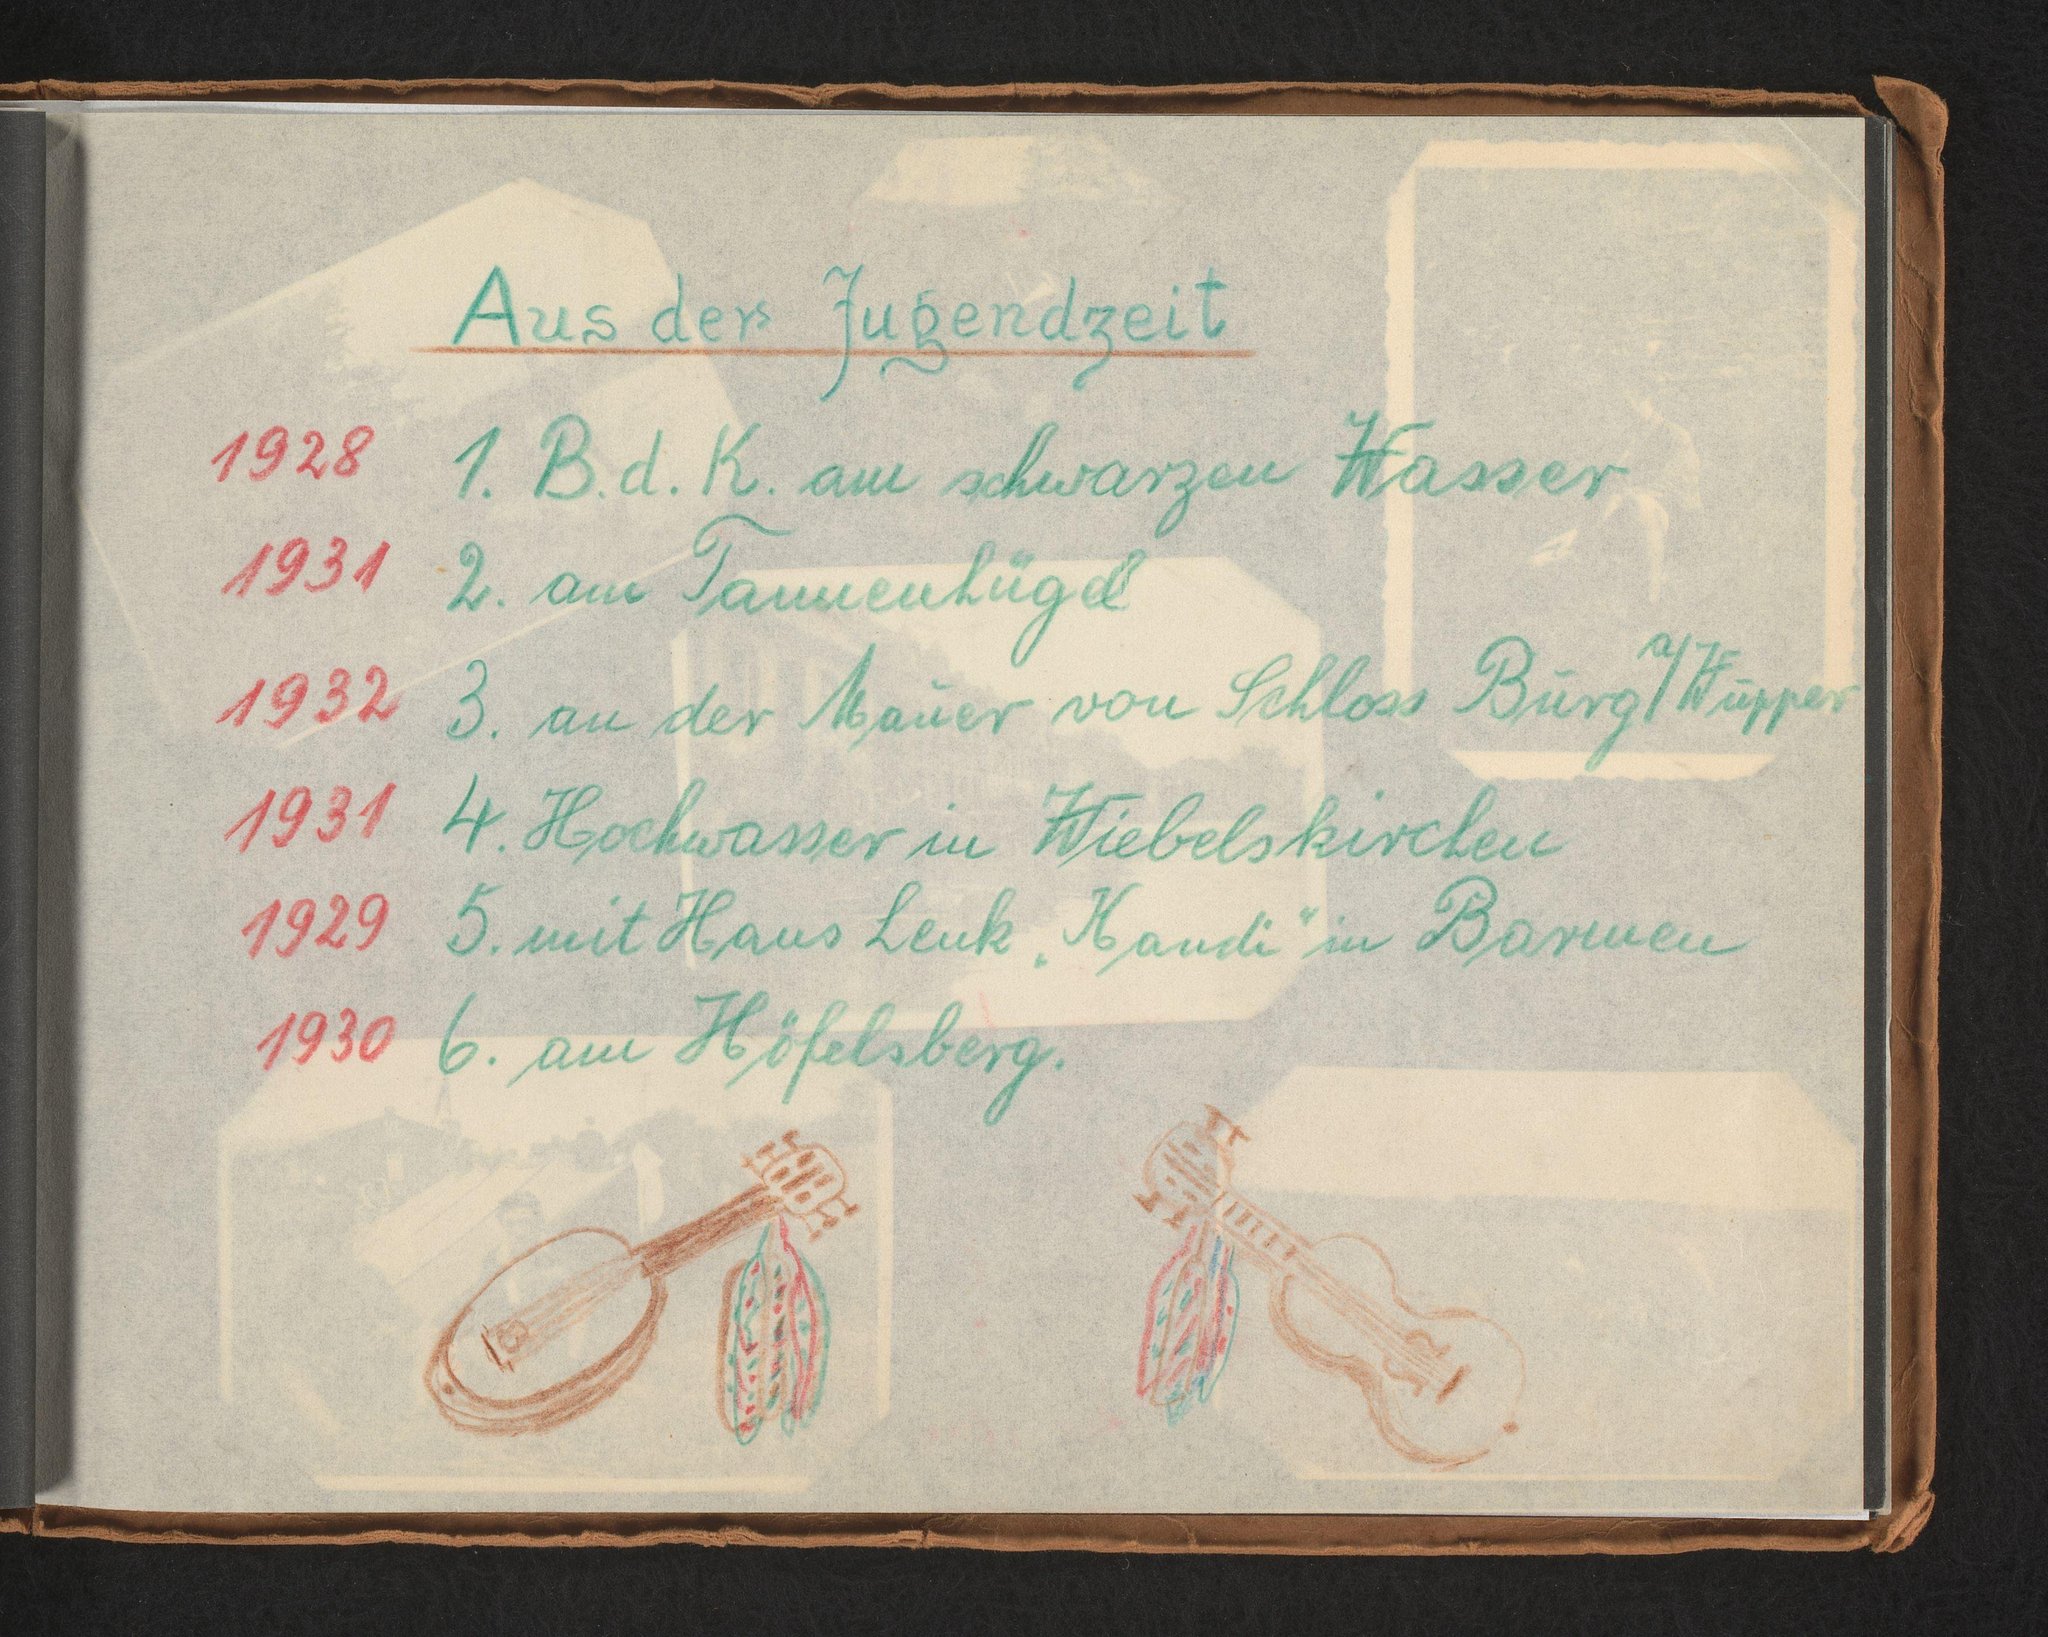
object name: album leaf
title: Aus der Jugendzeit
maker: werner neufang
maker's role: militair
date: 1943-1944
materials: paper, pencil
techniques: writing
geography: germany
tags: werner neufang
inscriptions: inscription: ‘Aus der Jugendzeit / ...’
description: Blad met tekst over de zes foto's op het volgende blad, uit de jeugd van Werner tussen 1928-1932. Onderaan twee tekeningetjes van gitaren. Tussenblad tussen bladzijde 14 en 15. Onderdeel van een fotoalbum over de Duitse Werner Neufang van de Kriegsmarine en de Nederlandse Thea Driesen.